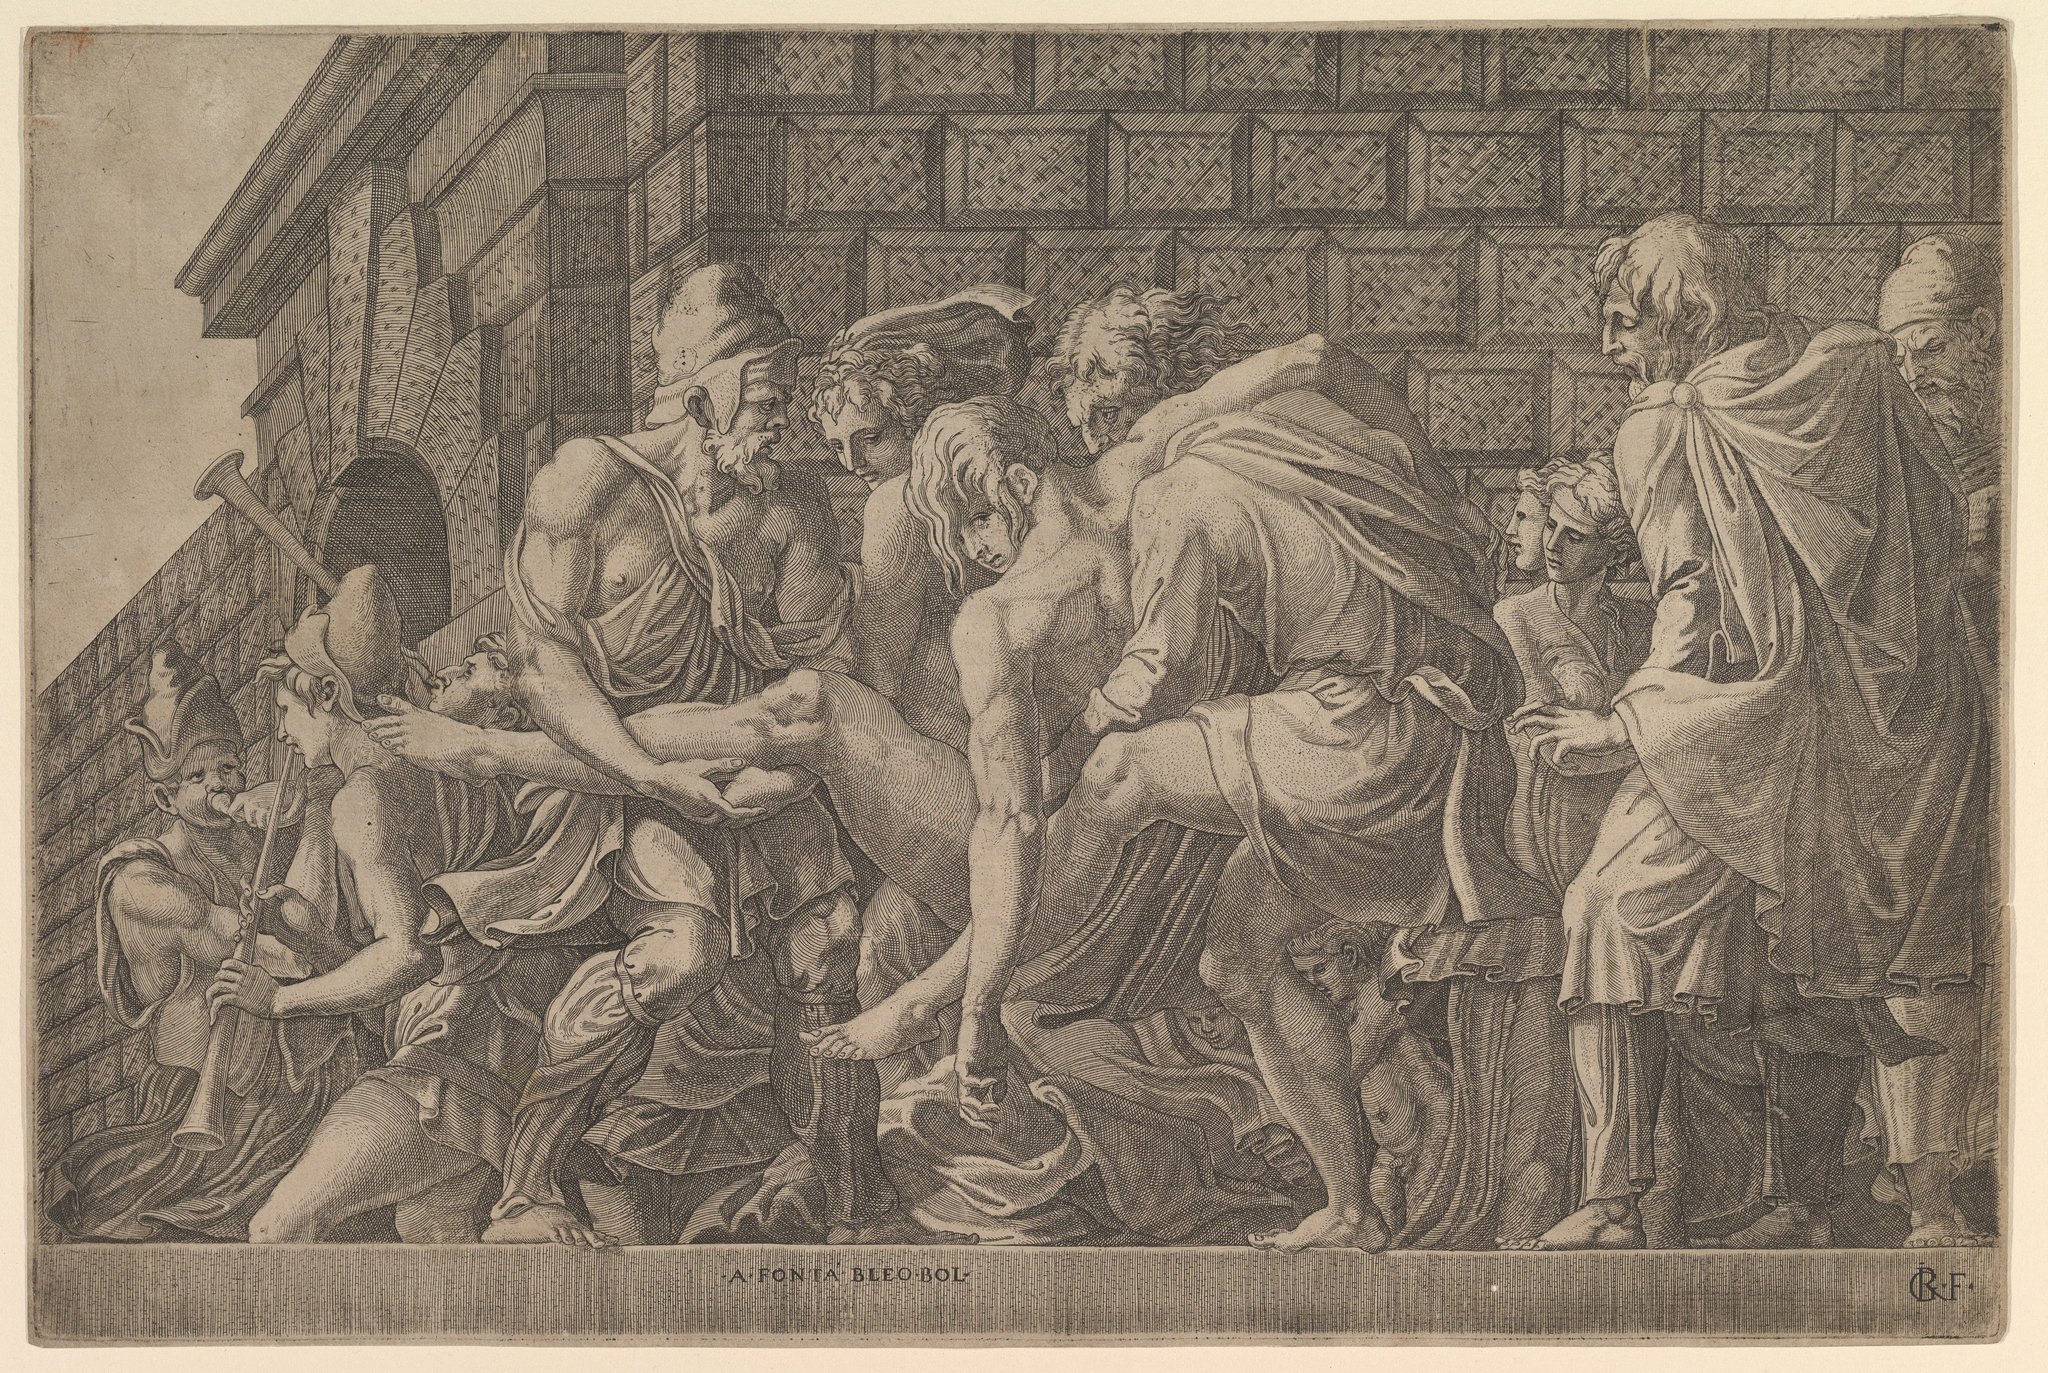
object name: print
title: The Wounded Paris Carried from the Field of Battle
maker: master fg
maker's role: artist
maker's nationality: italian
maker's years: 1530-1560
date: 1540-1560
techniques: engraving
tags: suffering,men